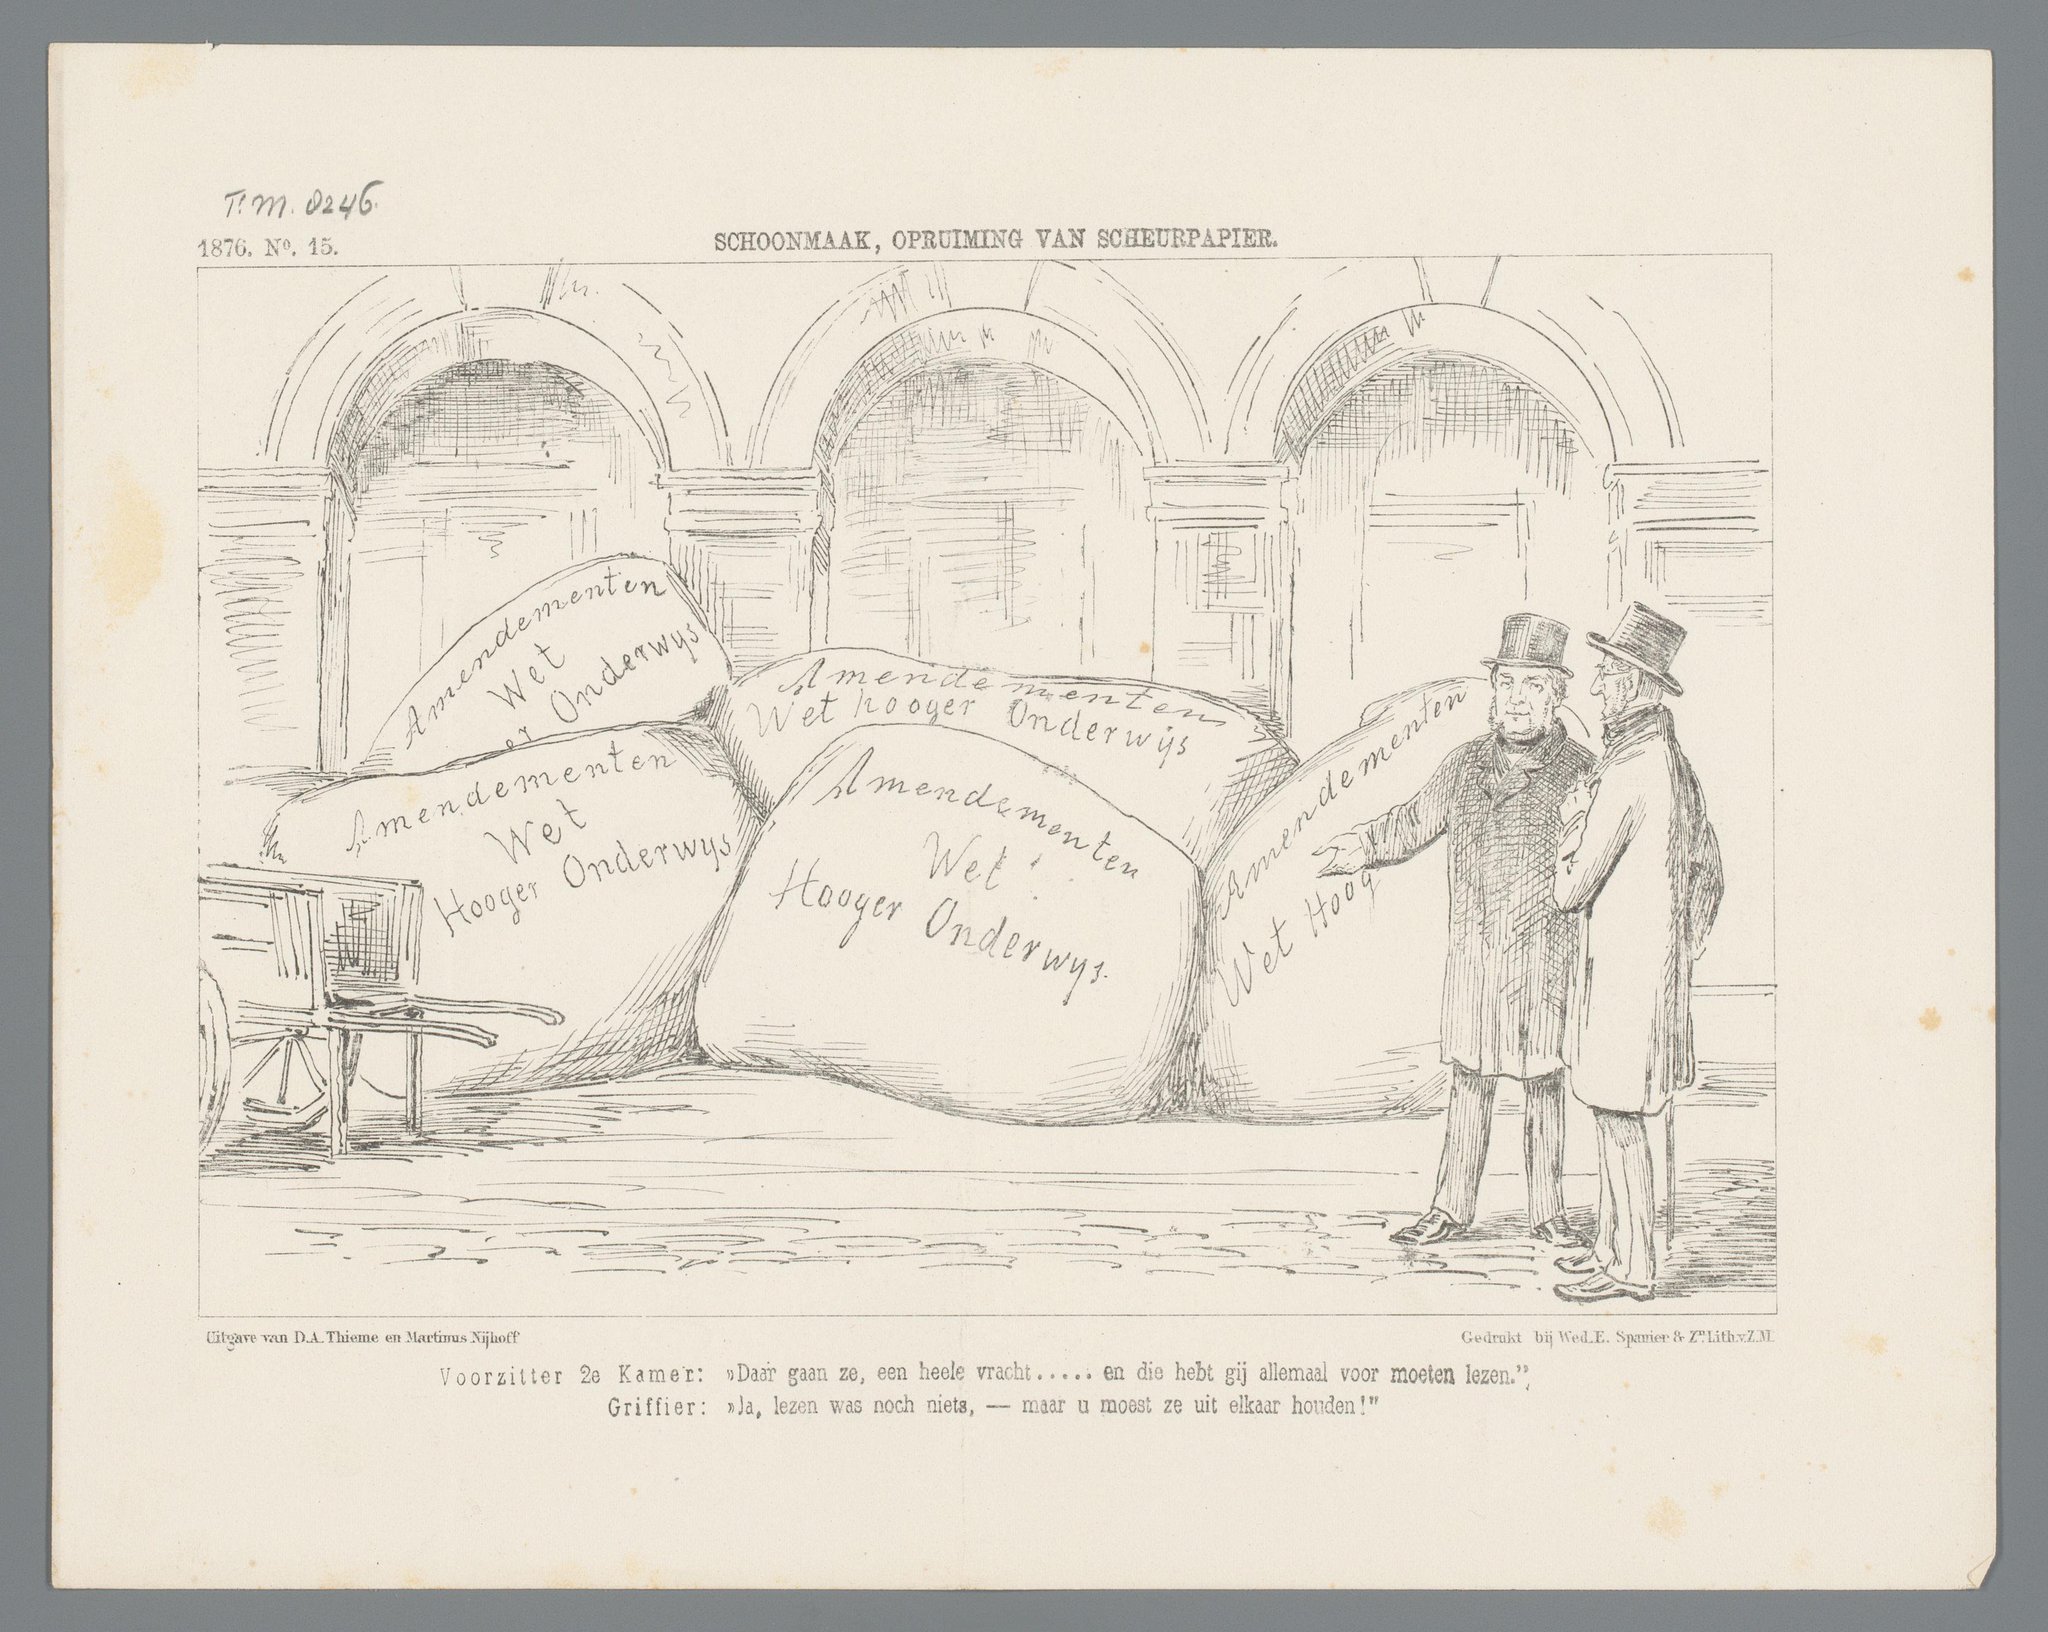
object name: print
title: Spotprent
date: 1876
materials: paper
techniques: lithograph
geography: the hague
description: Spotprent . Plaat verschenen bij het weekblad De Nederlandsche Spectator, nr. 15, 1876.